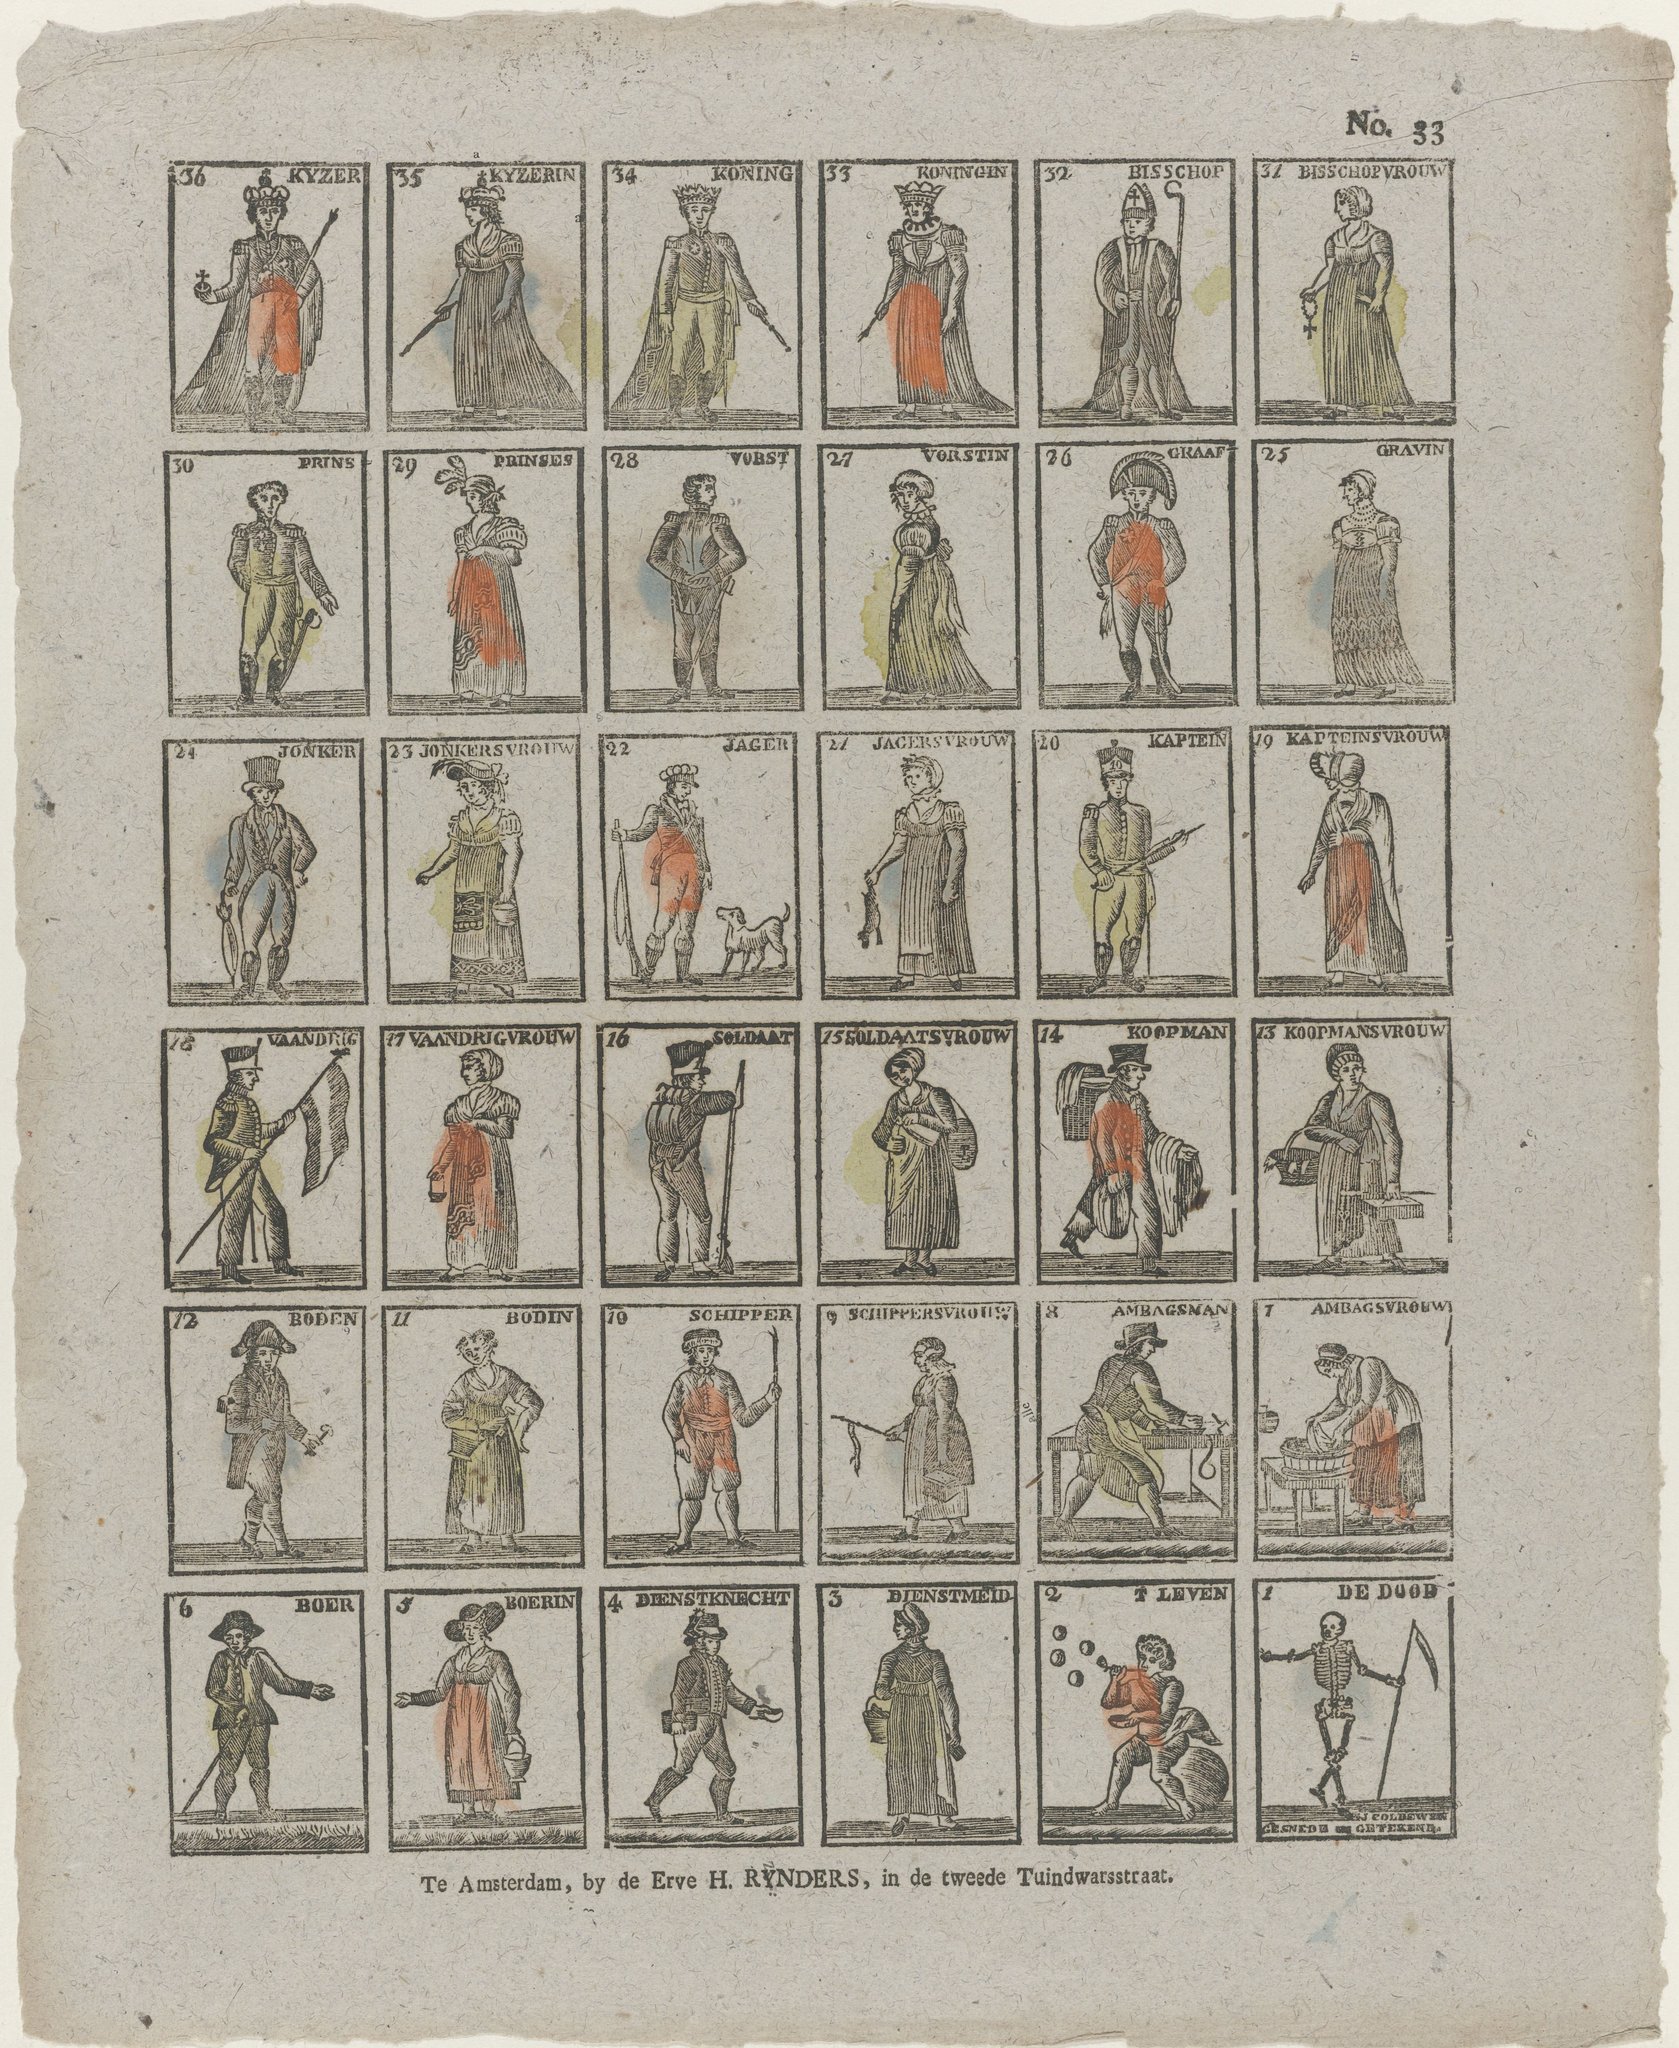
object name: popular print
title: Floskaartjes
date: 1831-1854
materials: paper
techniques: colour, letterpress printing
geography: amsterdam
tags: symbols and personifications of death, social position, playing-cards, nobility and patriciate; chivalry, knighthood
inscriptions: collector's mark: Lugt 2760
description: Blad met 36 speelkaarten (floskaartjes) met voorstellingen van verschillende figuren. De afbeeldingen vormen achttien paren, aflopend genummerd van bovenaan links nummer 36 tot onderaan rechts nummer 1. Op de twee laagste nummers na tonen ze zeventien koppels, man en vrouw, met de man net één nummer hoger dan de vrouw, waarbij elk paar een beroep of een maatschappelijke positie voorstelt. Genummerd rechtsboven: No. 33.